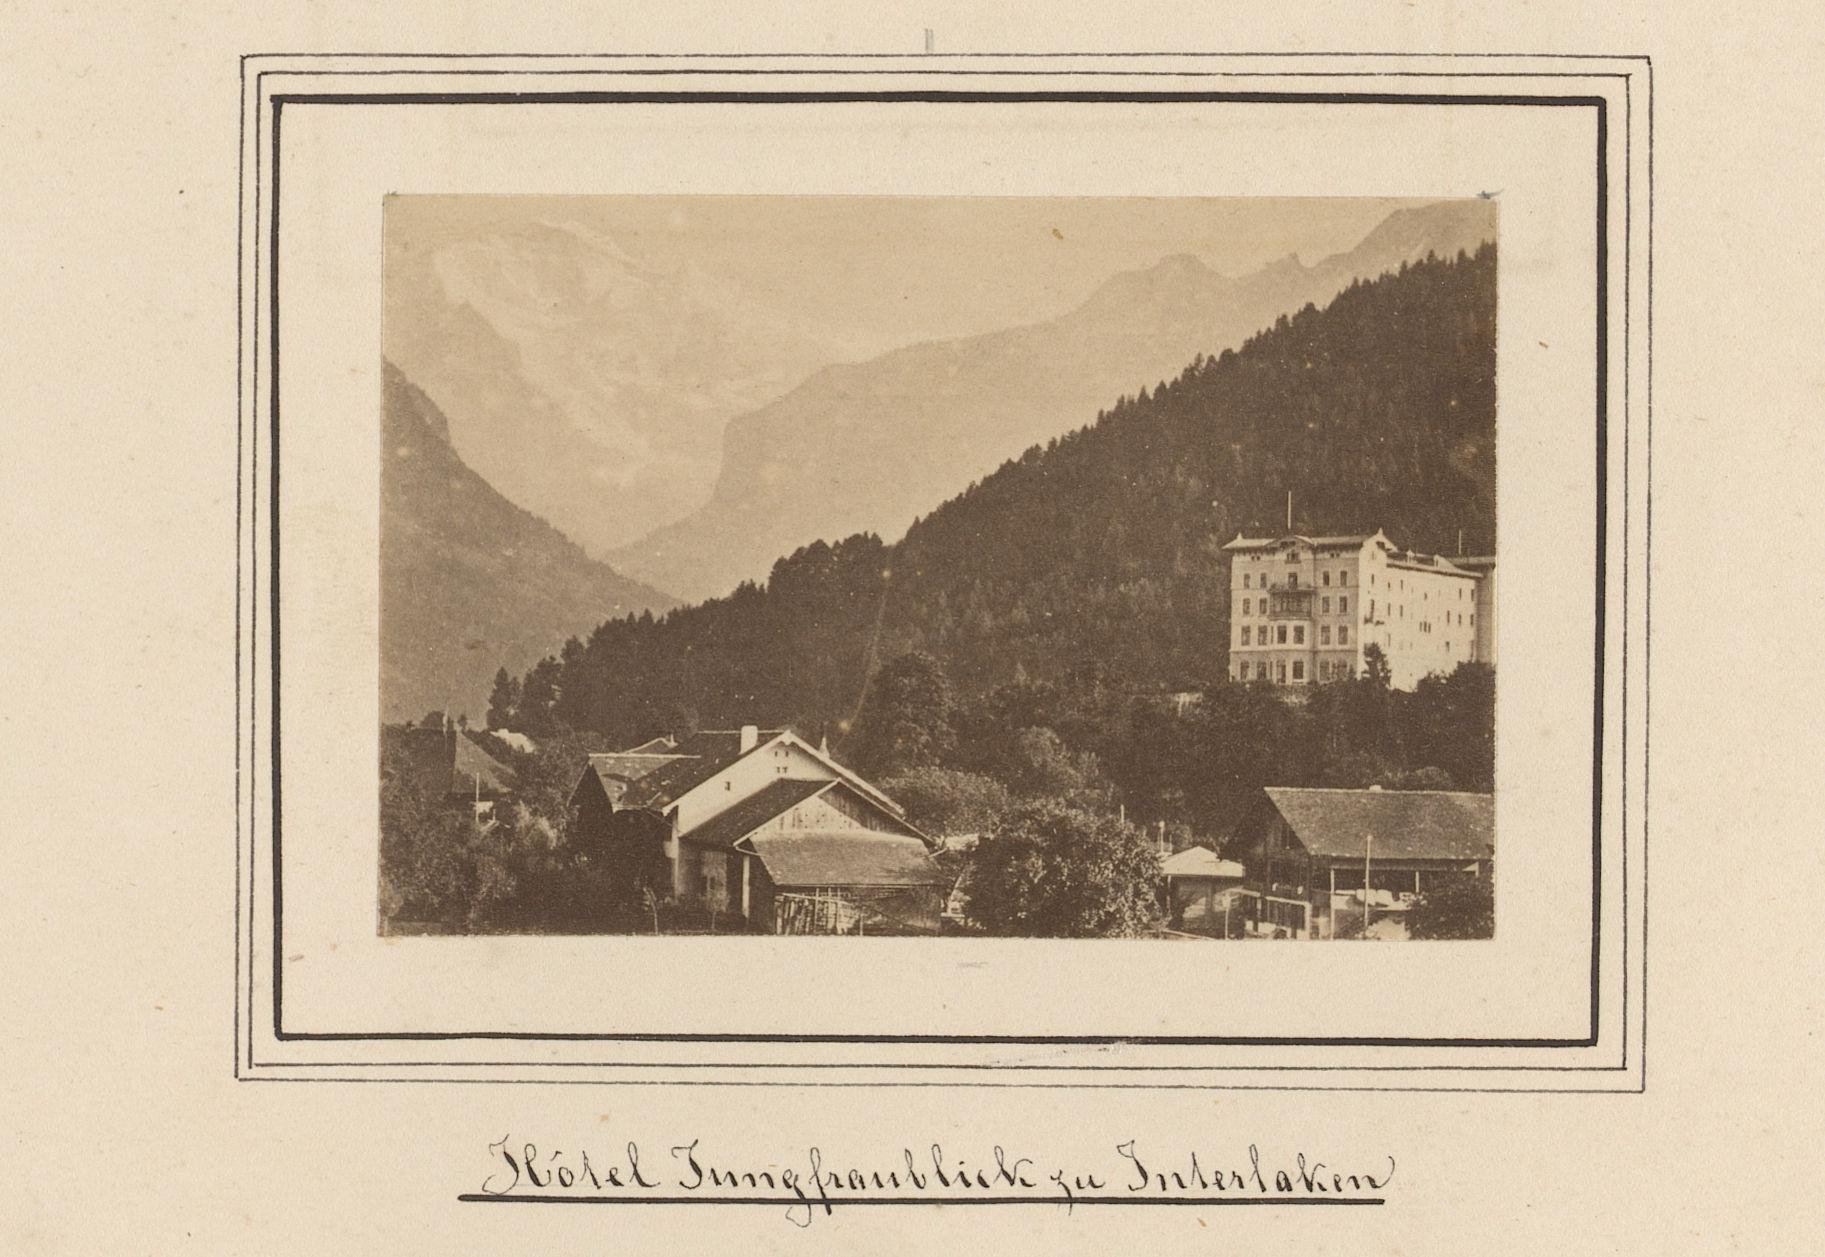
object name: album leaf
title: Hôtel Jungfraublick zu Interlaken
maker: Anonymous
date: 1870-1890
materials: paper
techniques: albumen print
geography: interlaken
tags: hotel, hostelry, inn, mountains